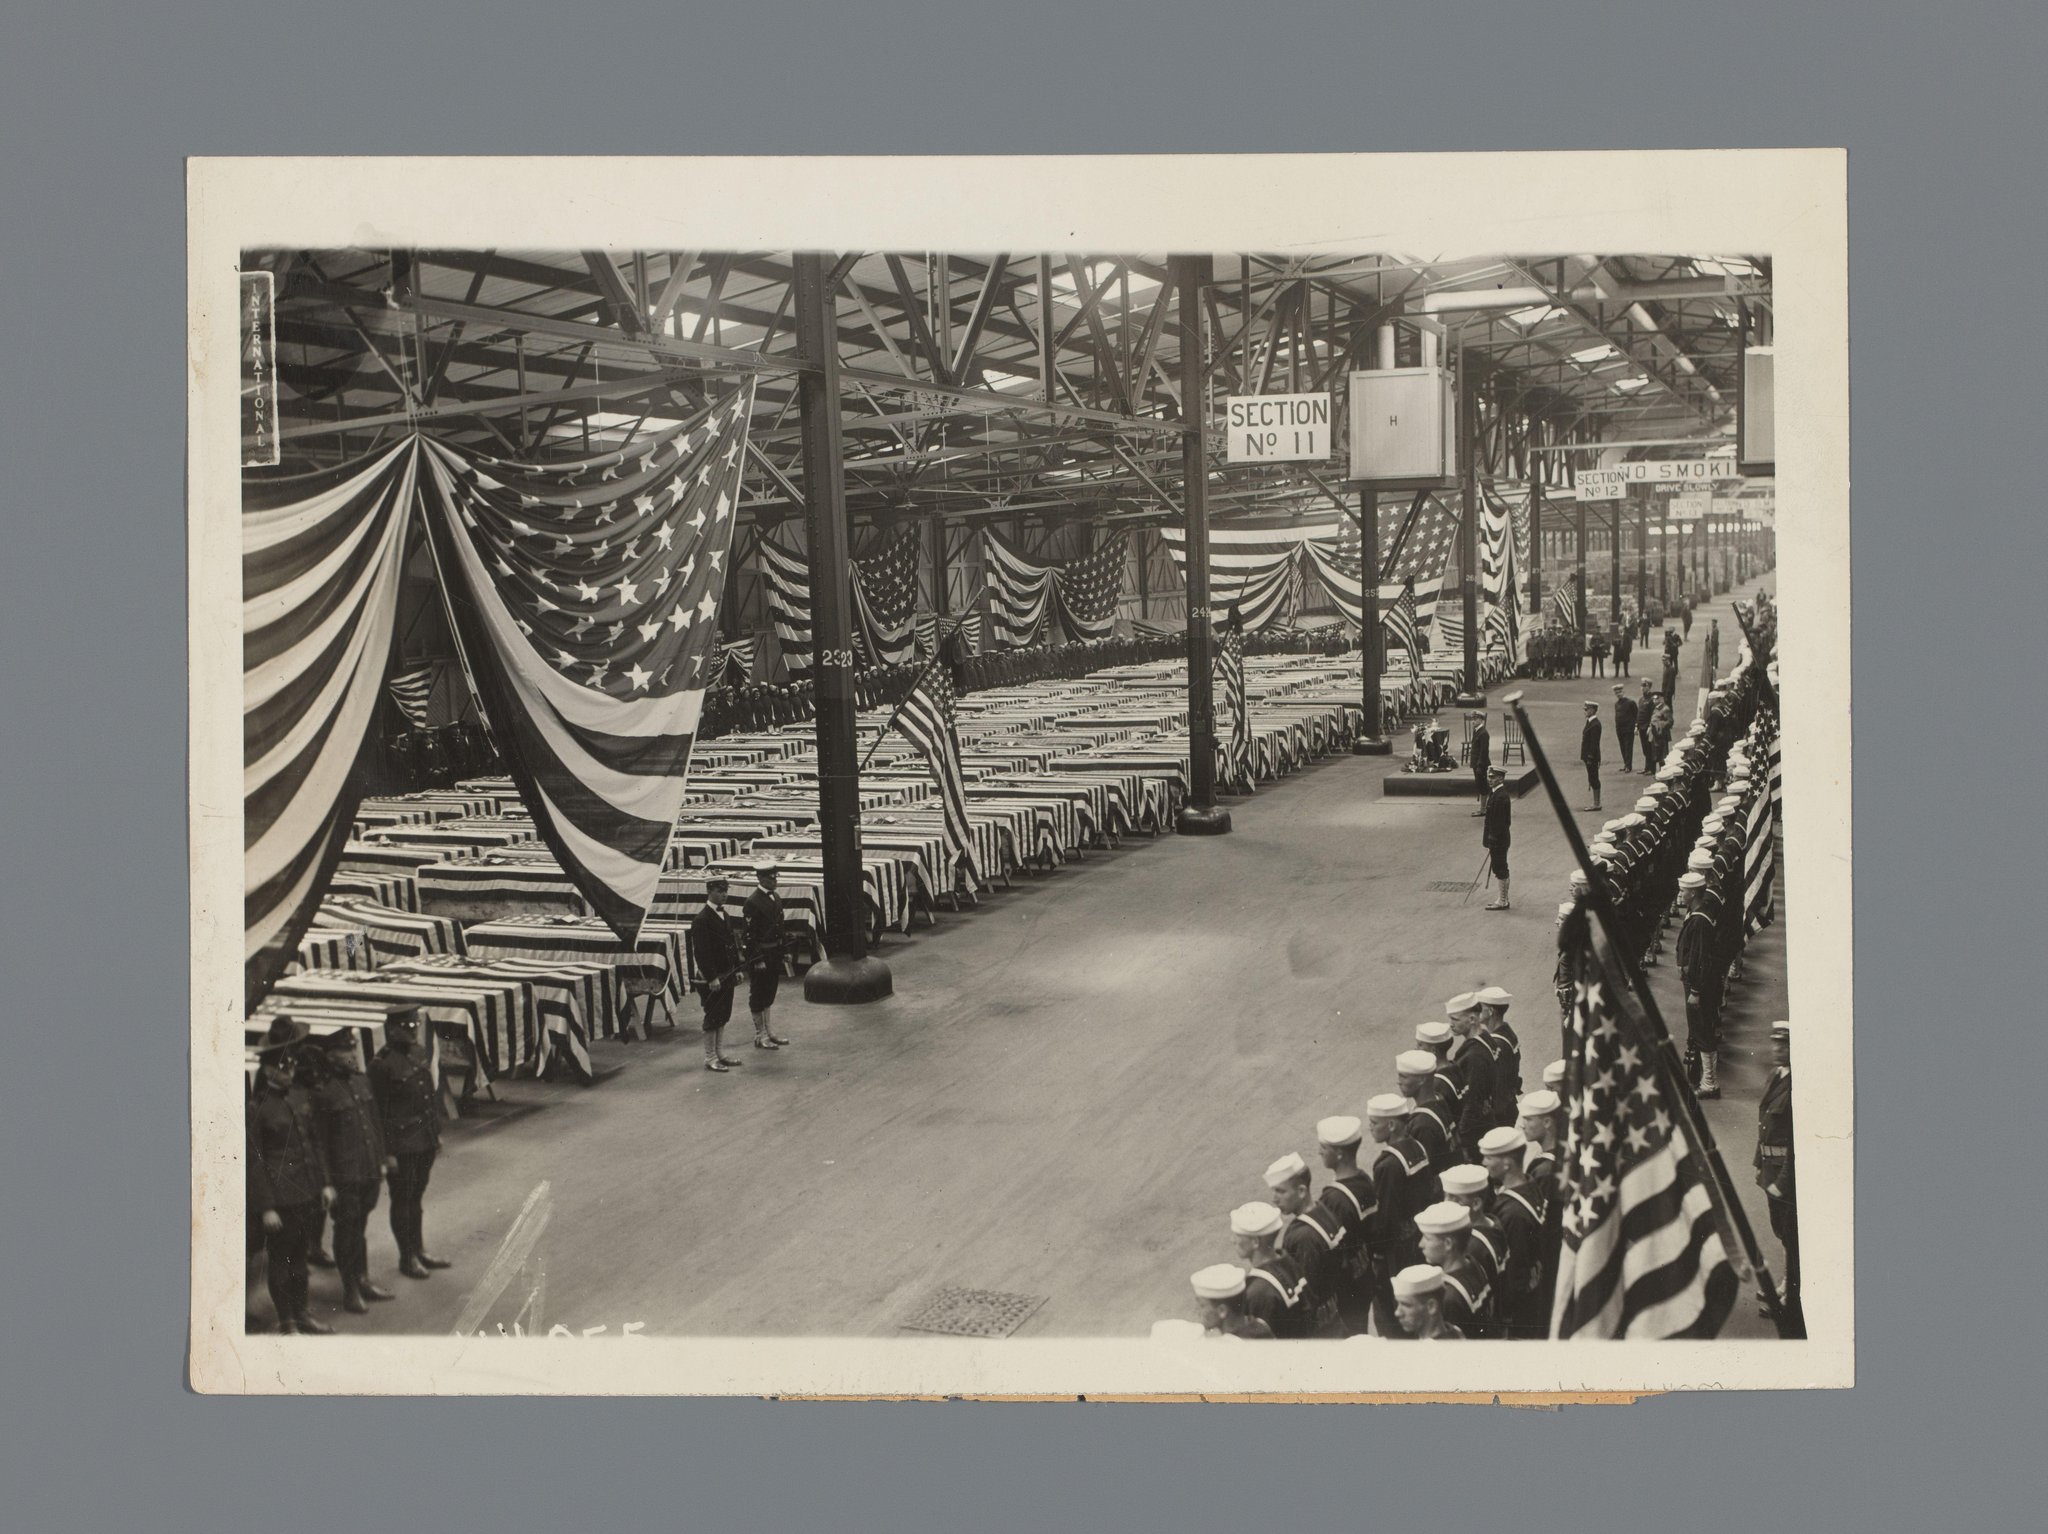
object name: photograph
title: 157 Doodskisten van Amerikaanse militairen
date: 1917-1918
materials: photographic support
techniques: gelatin silver print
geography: new york city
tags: new york (city)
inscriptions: inscription: ‘INTERNATIONAL’, stamp, inscription: ‘WATCH YOUR CREDIT / 113055 International / BRINGING BACK THE BODIES OF THE MEN WHO GAVE UP THEIR LIVES ON THE BATTLE FIELDS OF FRANCE / Brooklyn, N.Y. …… Memorial services are held over the bodies of 157 men of the U.S. Navy and Marine Corps who arrived here from France. The services were held in the Bush Terminal Building here and Secretary Daniels delivered an eloquent tribute to the men who laid down their lives on the war torn fields of France. Over 100 Red Cross Nurses, - A battalion of sailors and the Woman’s Motor Corps, together with many relatives of the heroes attended. Invocations were read by Chaplain W. D. Isaacs and Rabbi H. Velt. The photo shows row upon row of flag draped caskets draped in the National emblem. (EM 5-20)’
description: Gezicht The Bush Terminal Building, Brooklyn, New York met 157 doodskisten van Amerikaanse militairen omgekomen tijdens de Eerste Wereldoorlog.